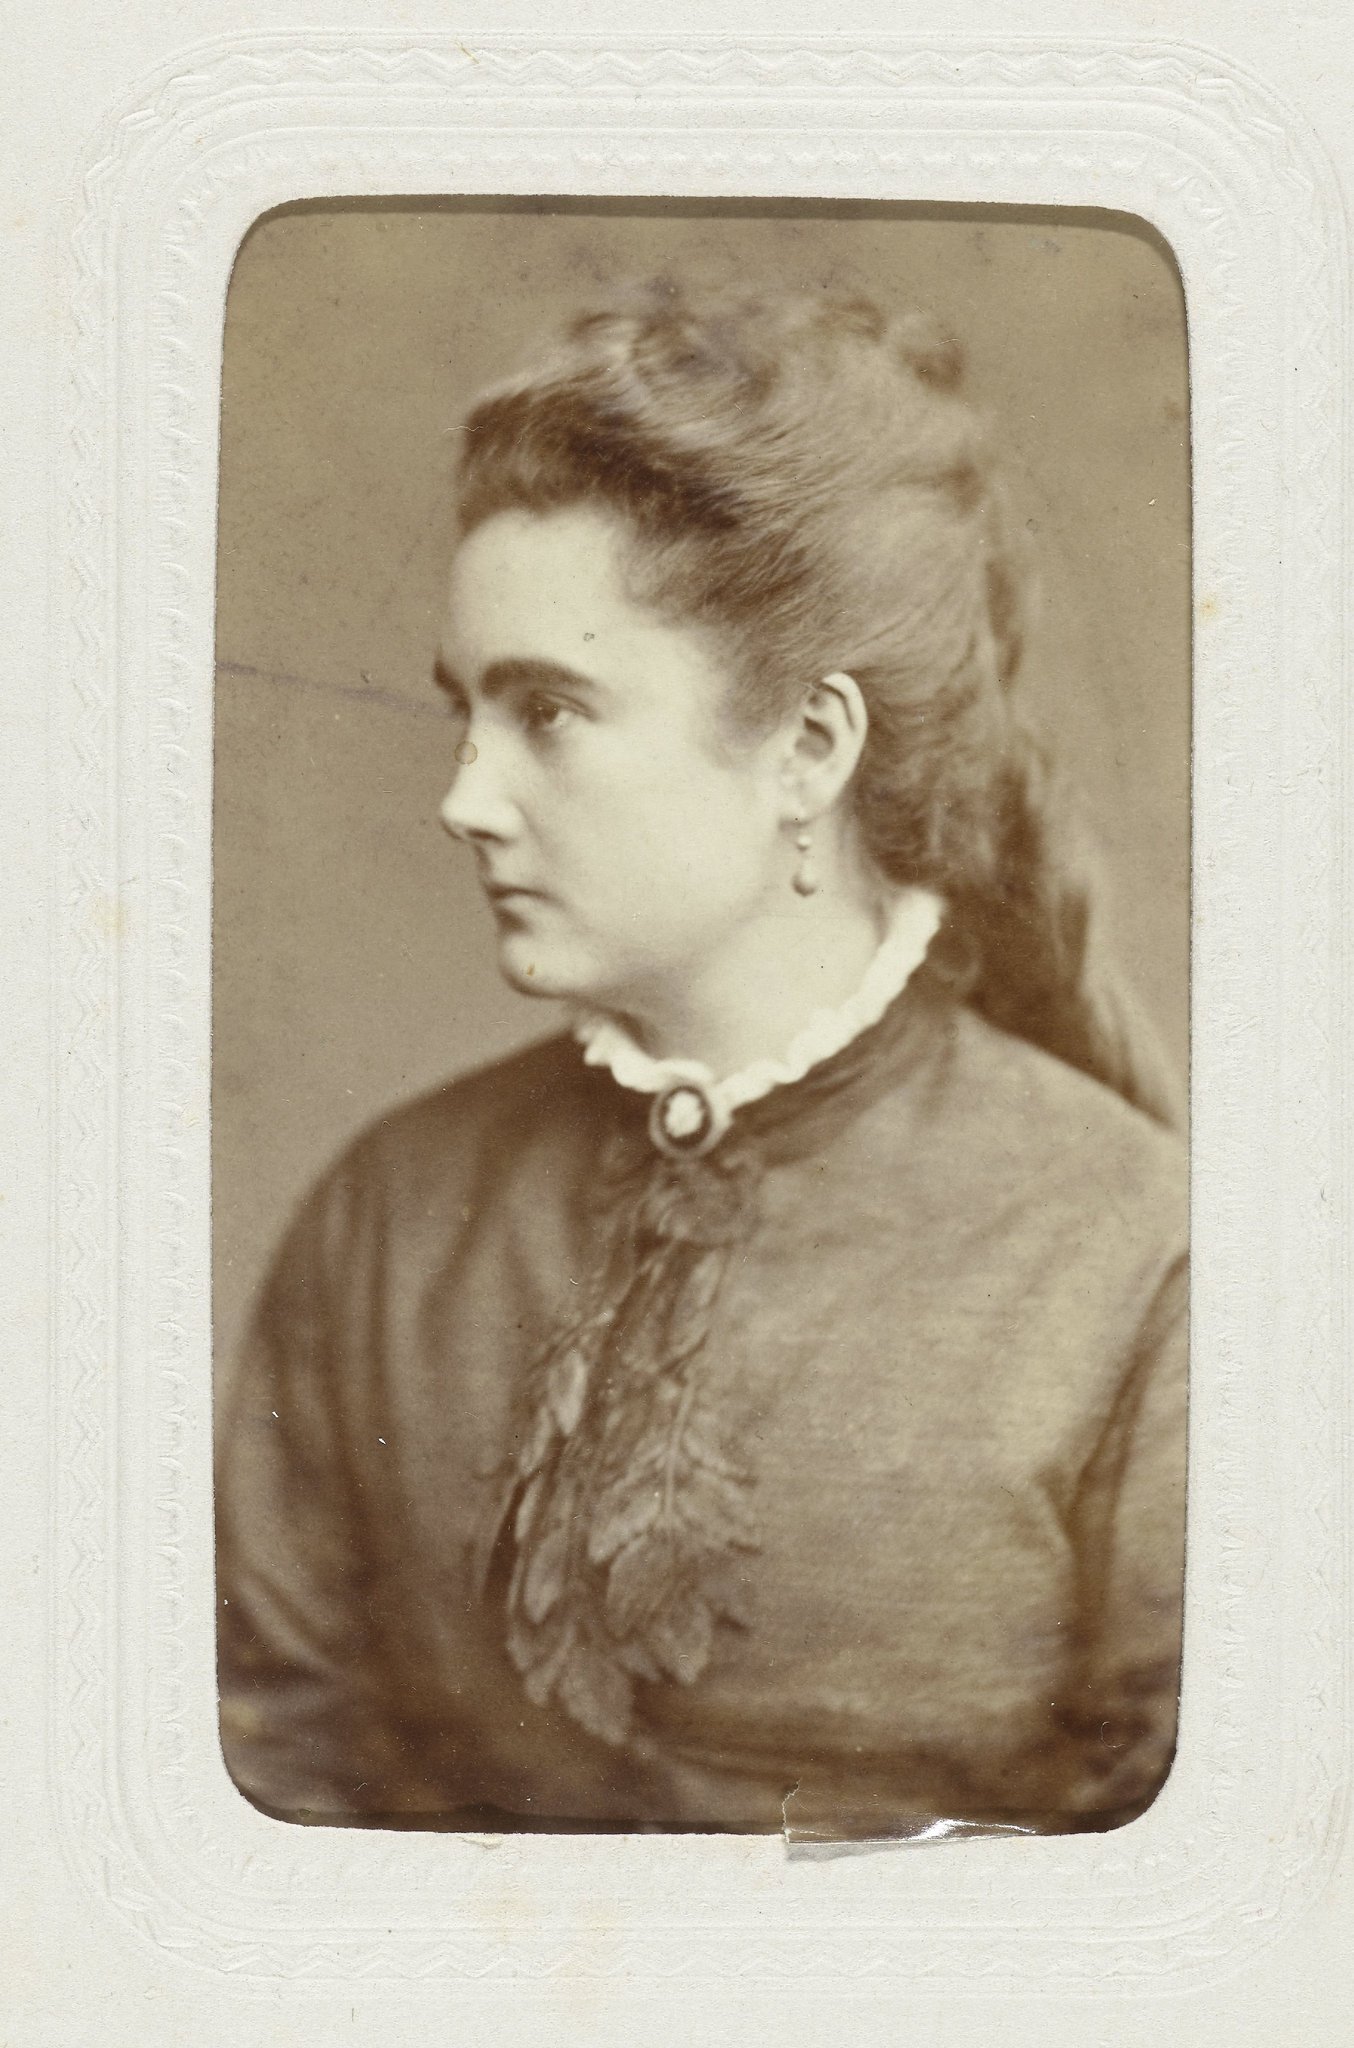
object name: carte de visite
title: Studioportret van een vrouw in een hooggesloten zwarte jurk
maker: albert greiner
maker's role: fotograaf, fotostudio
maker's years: 1833-1890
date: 1863-1866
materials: cardboard, paper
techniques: albumen print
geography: amsterdam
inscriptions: name: ‘Albert Greiner’